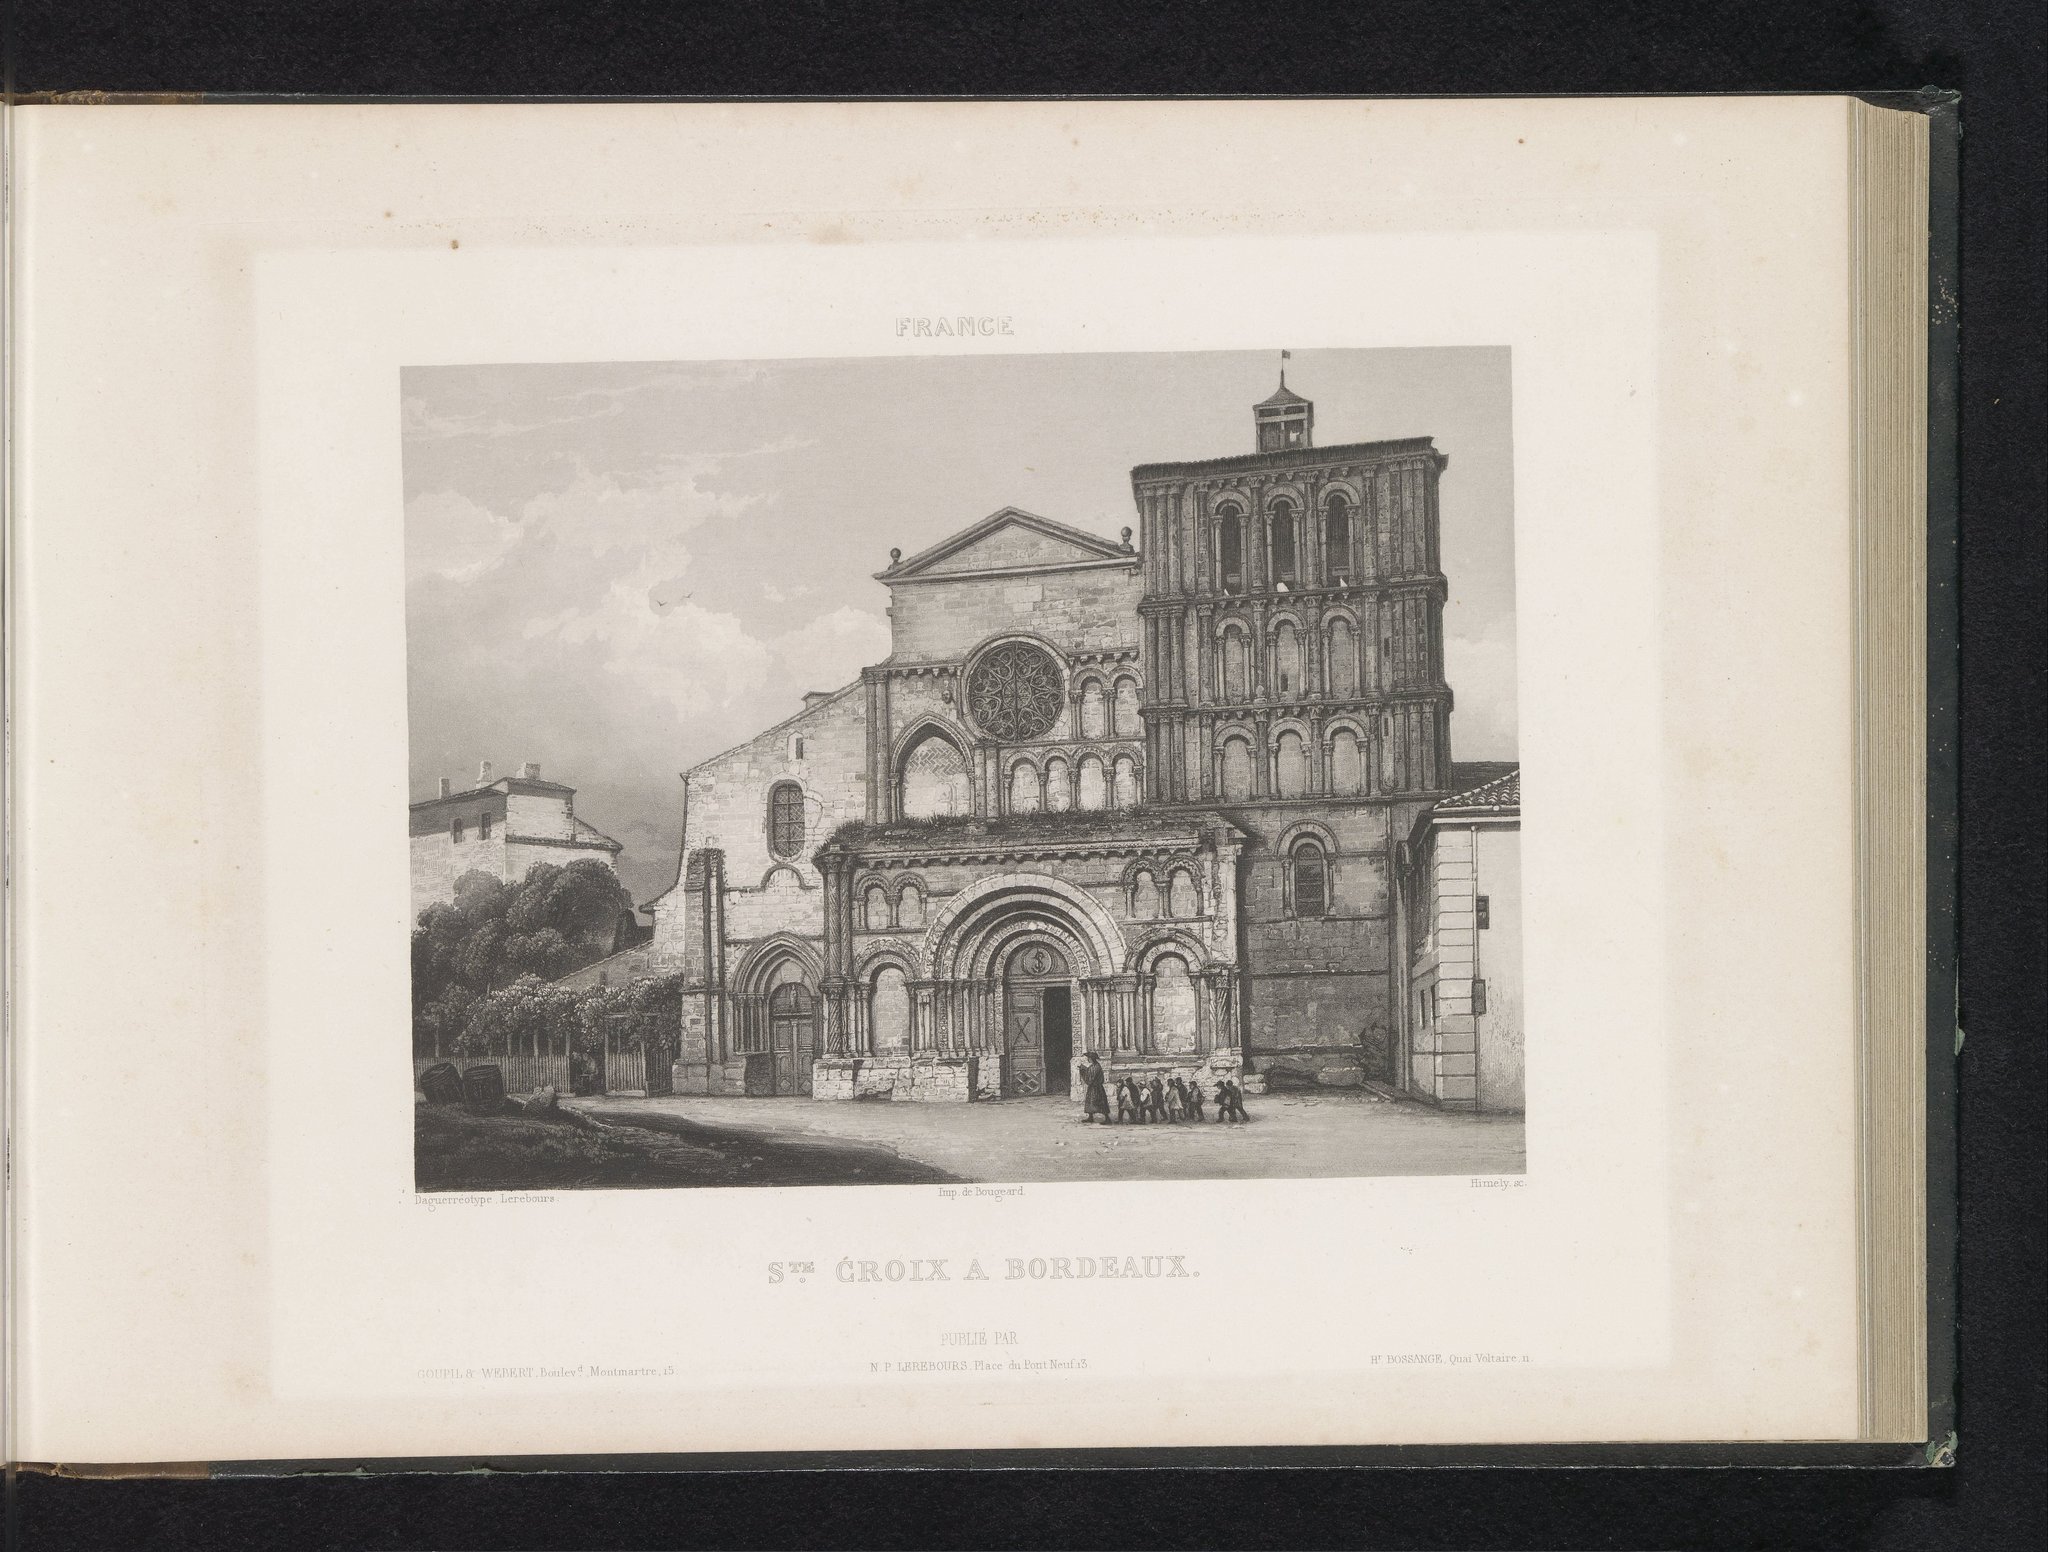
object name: print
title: Sainte Croix a Bordeaux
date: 1839-1841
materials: paper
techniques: aquatint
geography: paris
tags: ships (in general), façade (of house or building)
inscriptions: inscription: ‘Rittner & Goupil Boulevd Montmartre 15’, inscription: ‘N.P. Lerebours Place du Pont Neuf 15’, inscription: ‘Hr. Bossance Quai Voltaire 11’